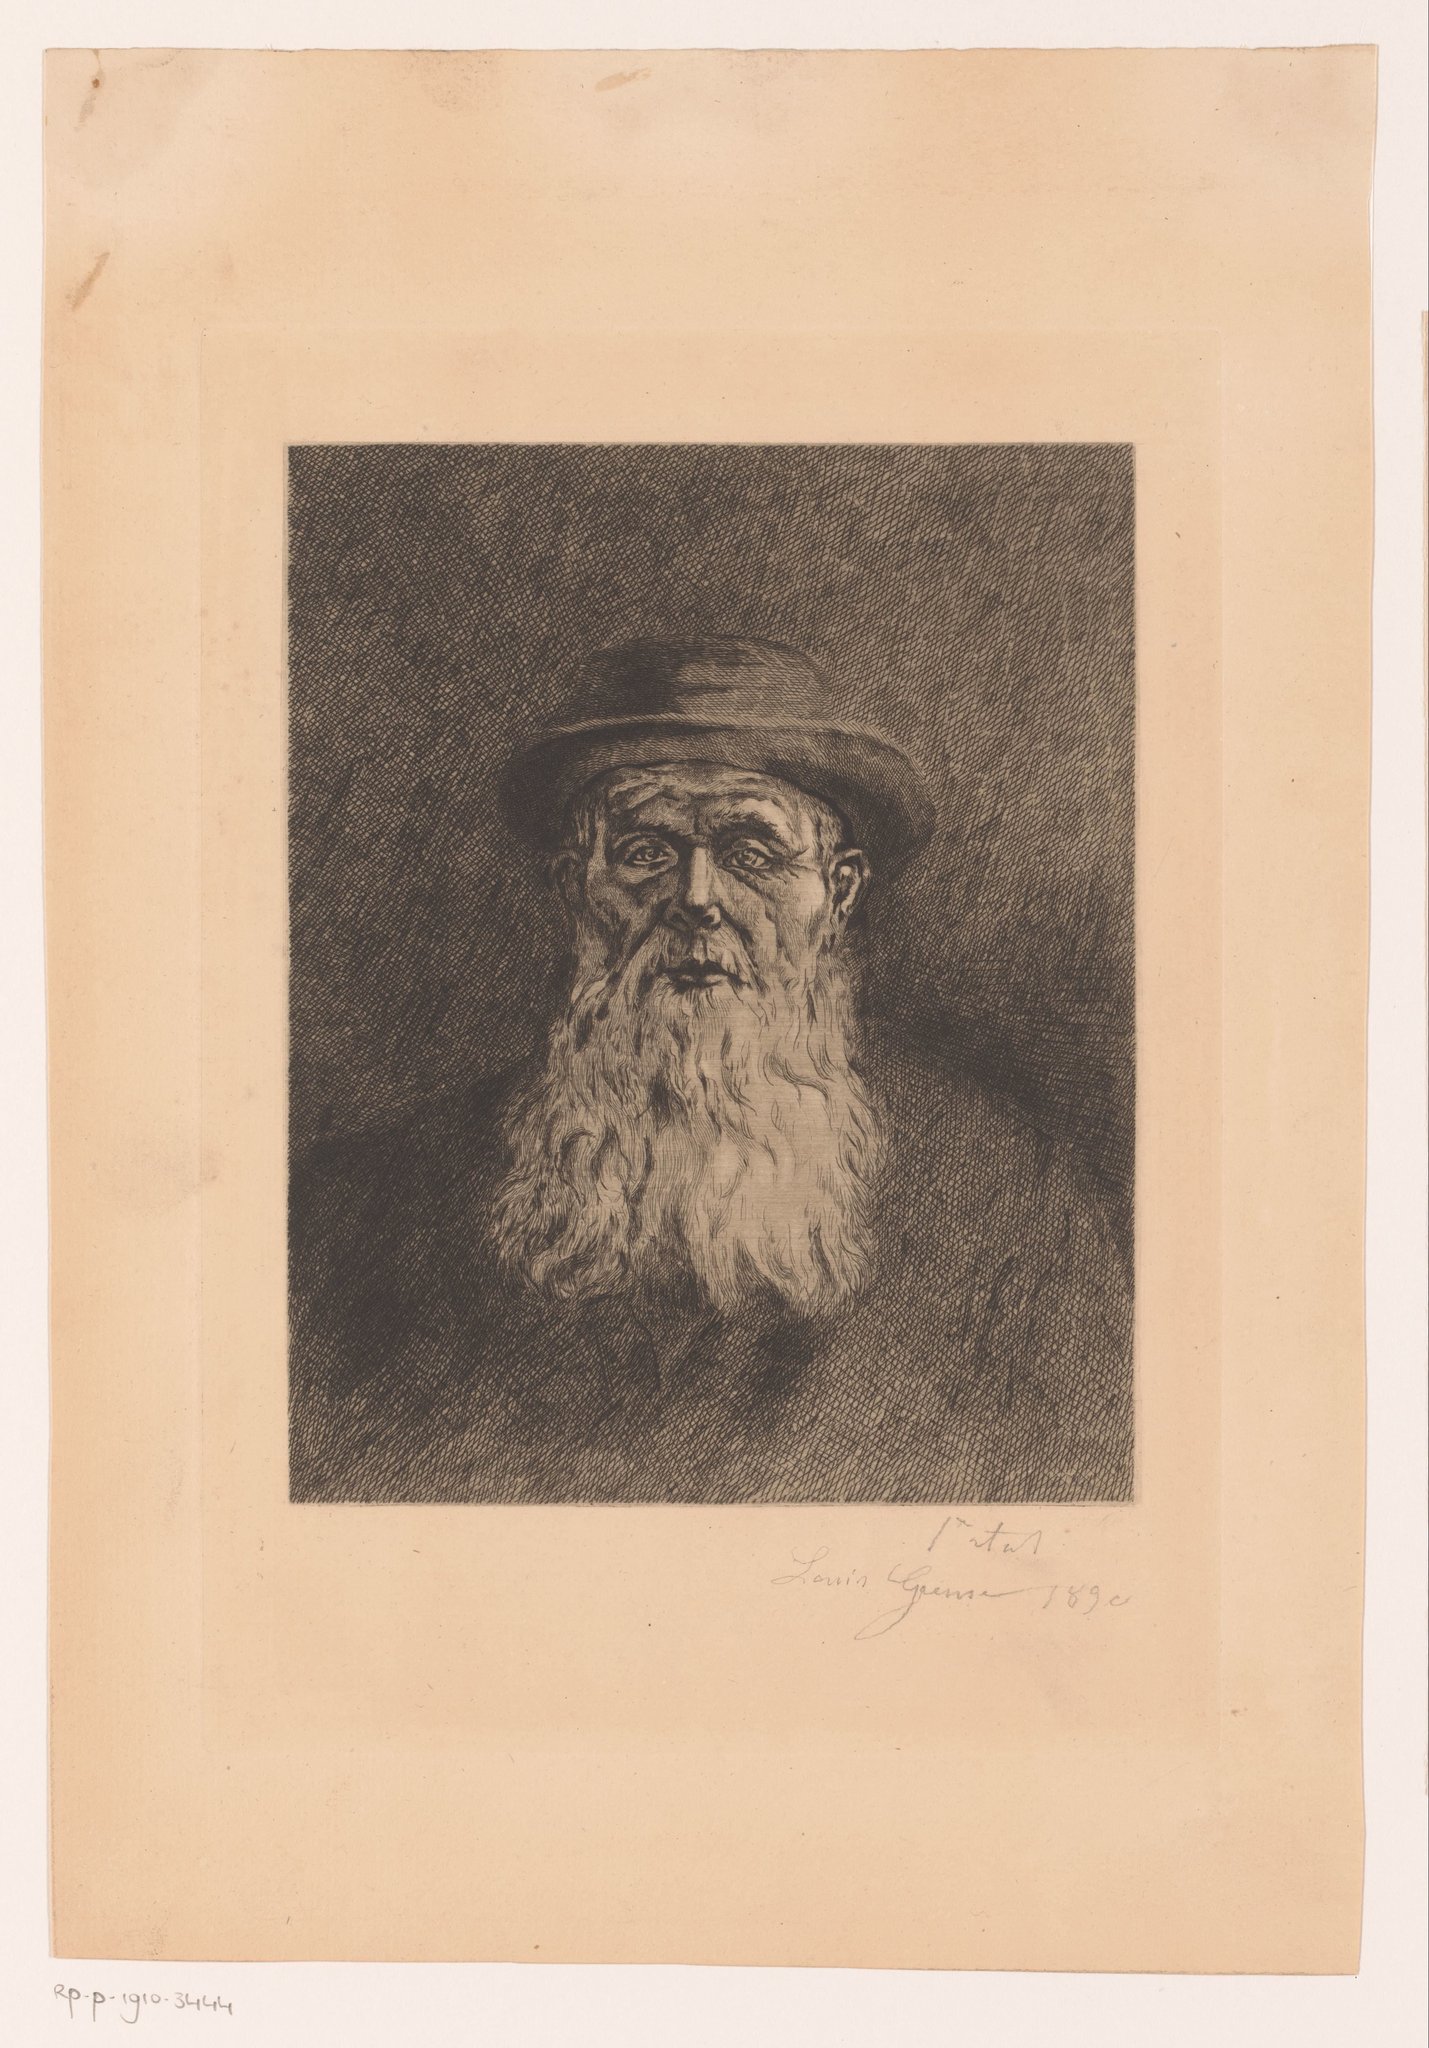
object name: print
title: Portret van een onbekende man met hoed en baard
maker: louis joseph greuse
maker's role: print maker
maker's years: 1863-1950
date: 1890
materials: paper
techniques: drypoint, etching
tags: anonymous historical person portrayed alone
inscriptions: annotation: ‘1er etat’, collector's mark: Lugt 2228